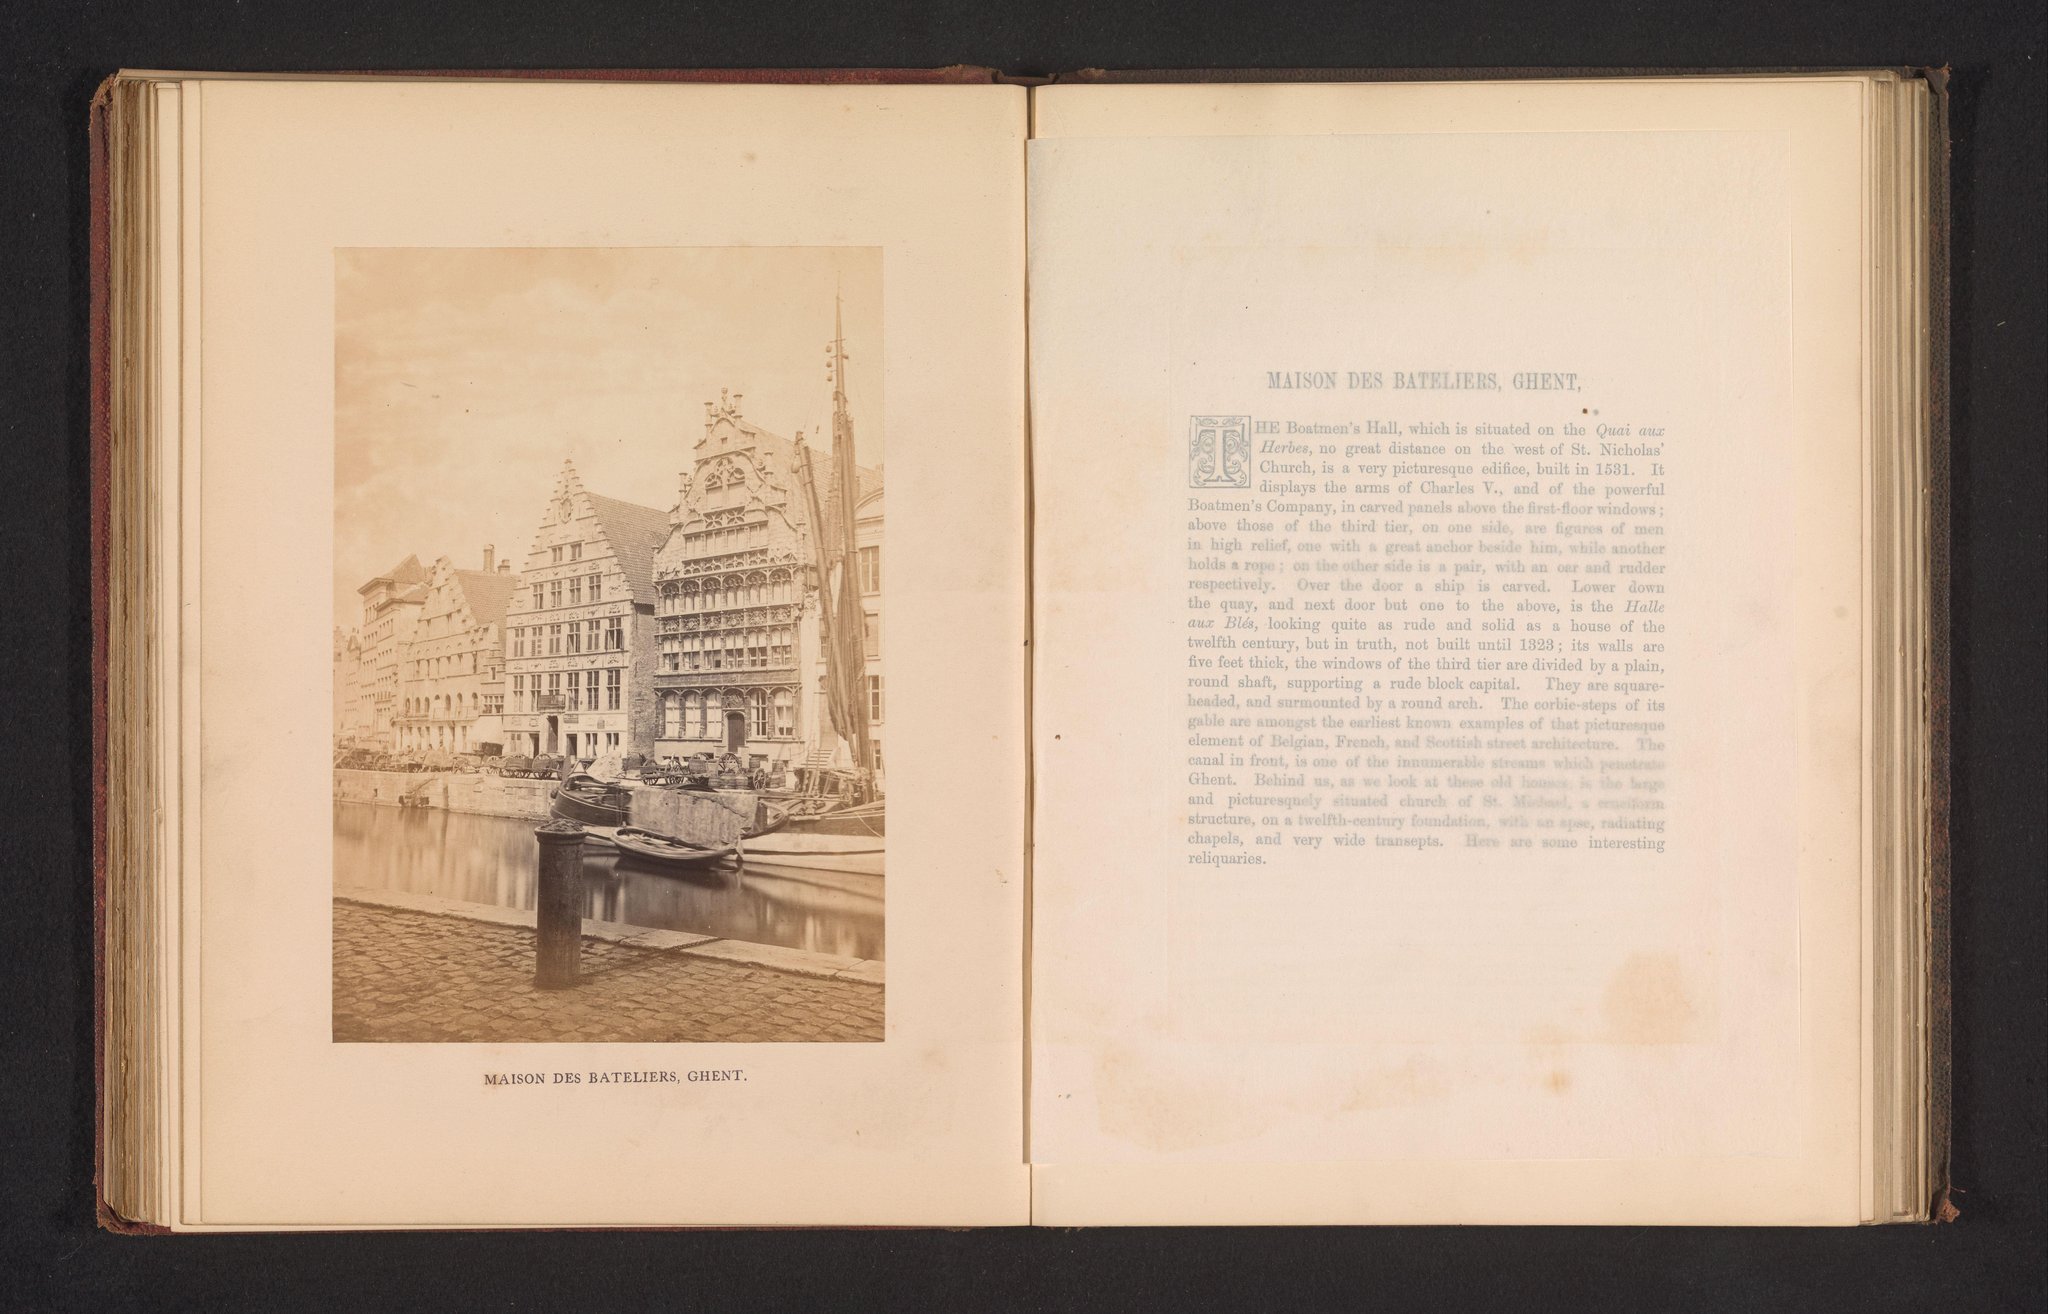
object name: page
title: Maison des bateliers, Ghent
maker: Anonymous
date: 1856-1866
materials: photographic support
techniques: albumen print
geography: ghent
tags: façade (of house or building), street